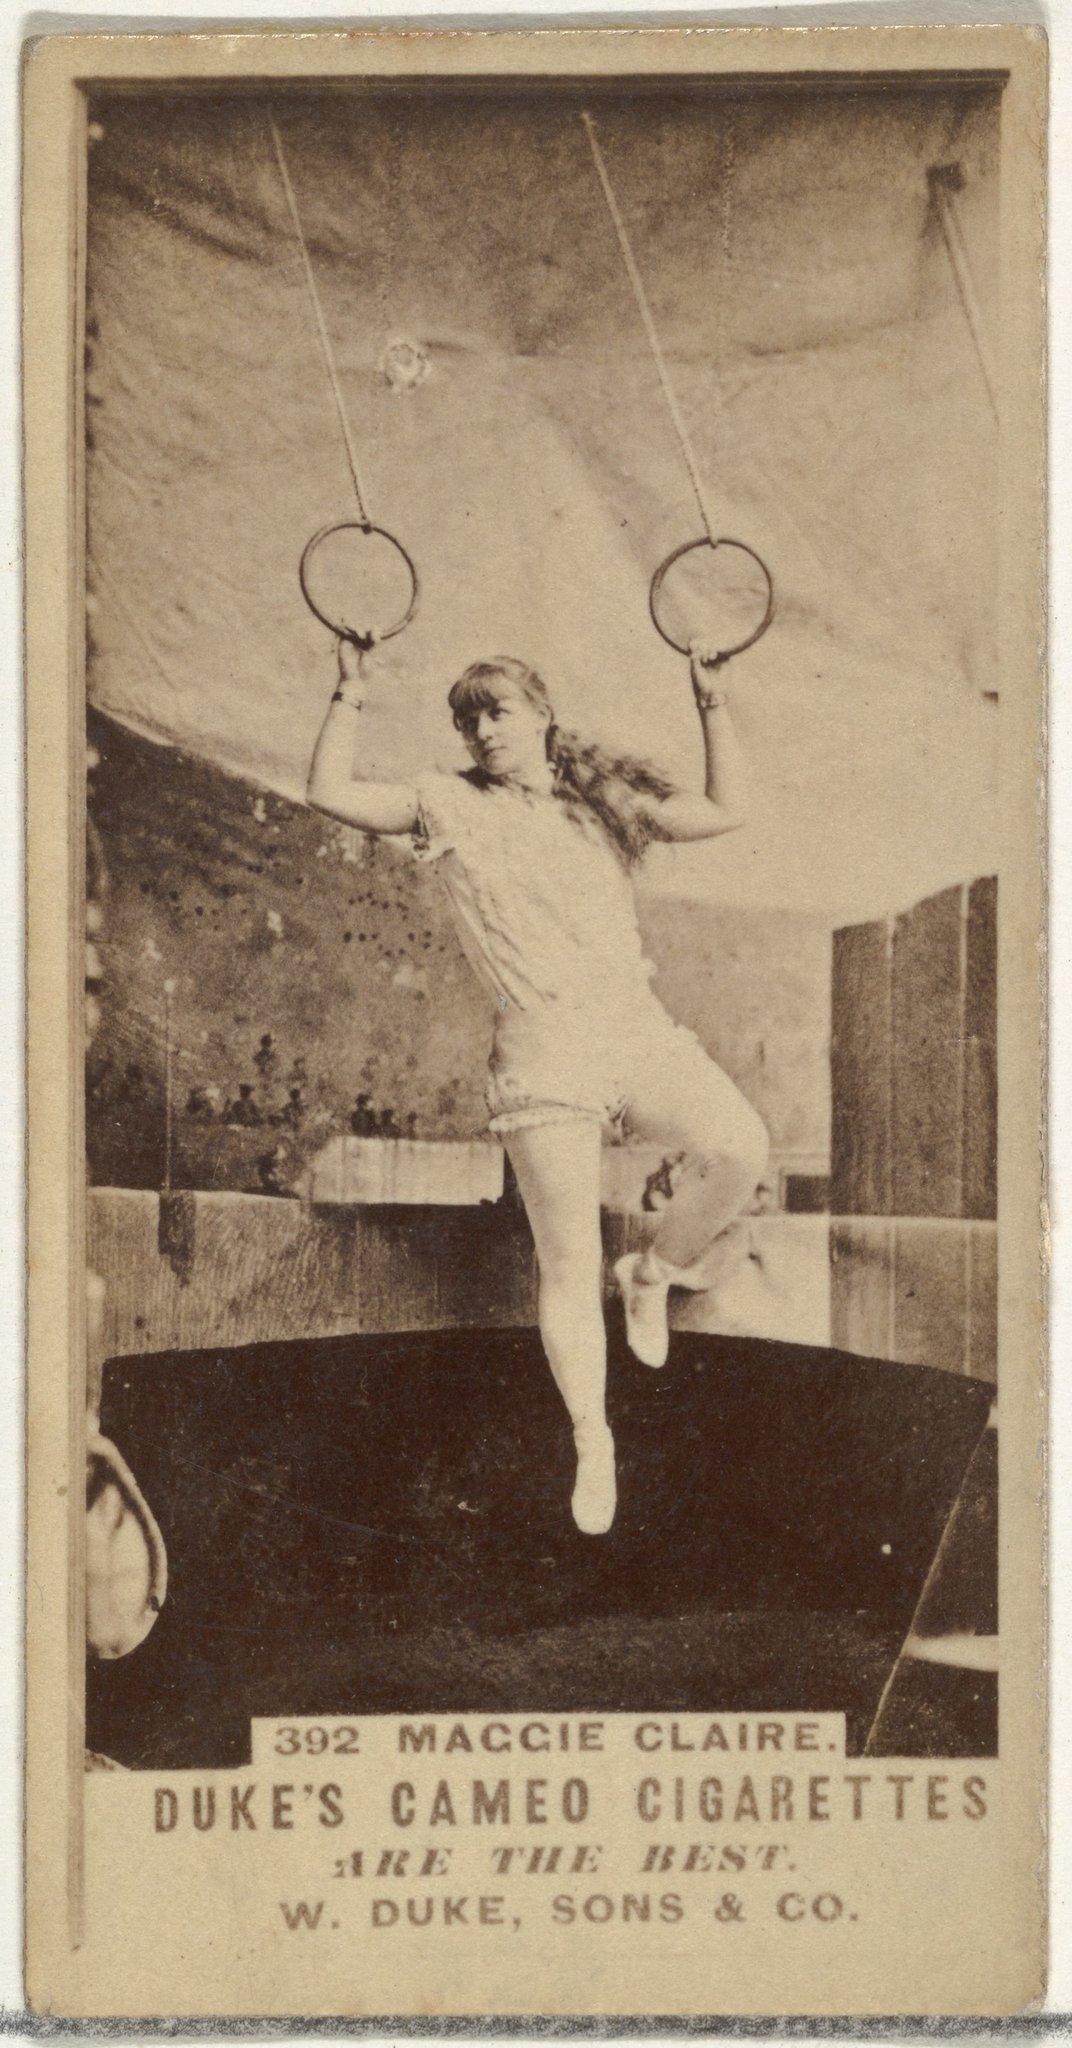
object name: photograph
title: Card Number 392, Maggie Claire, from the Actors and Actresses series (N145-5) issued by Duke Sons & Co. to promote Cameo Cigarettes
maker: w. duke, sons & co.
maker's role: publisher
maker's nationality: american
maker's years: 1870-1920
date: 1880-1889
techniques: albumen silver print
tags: portraits,women,actresses